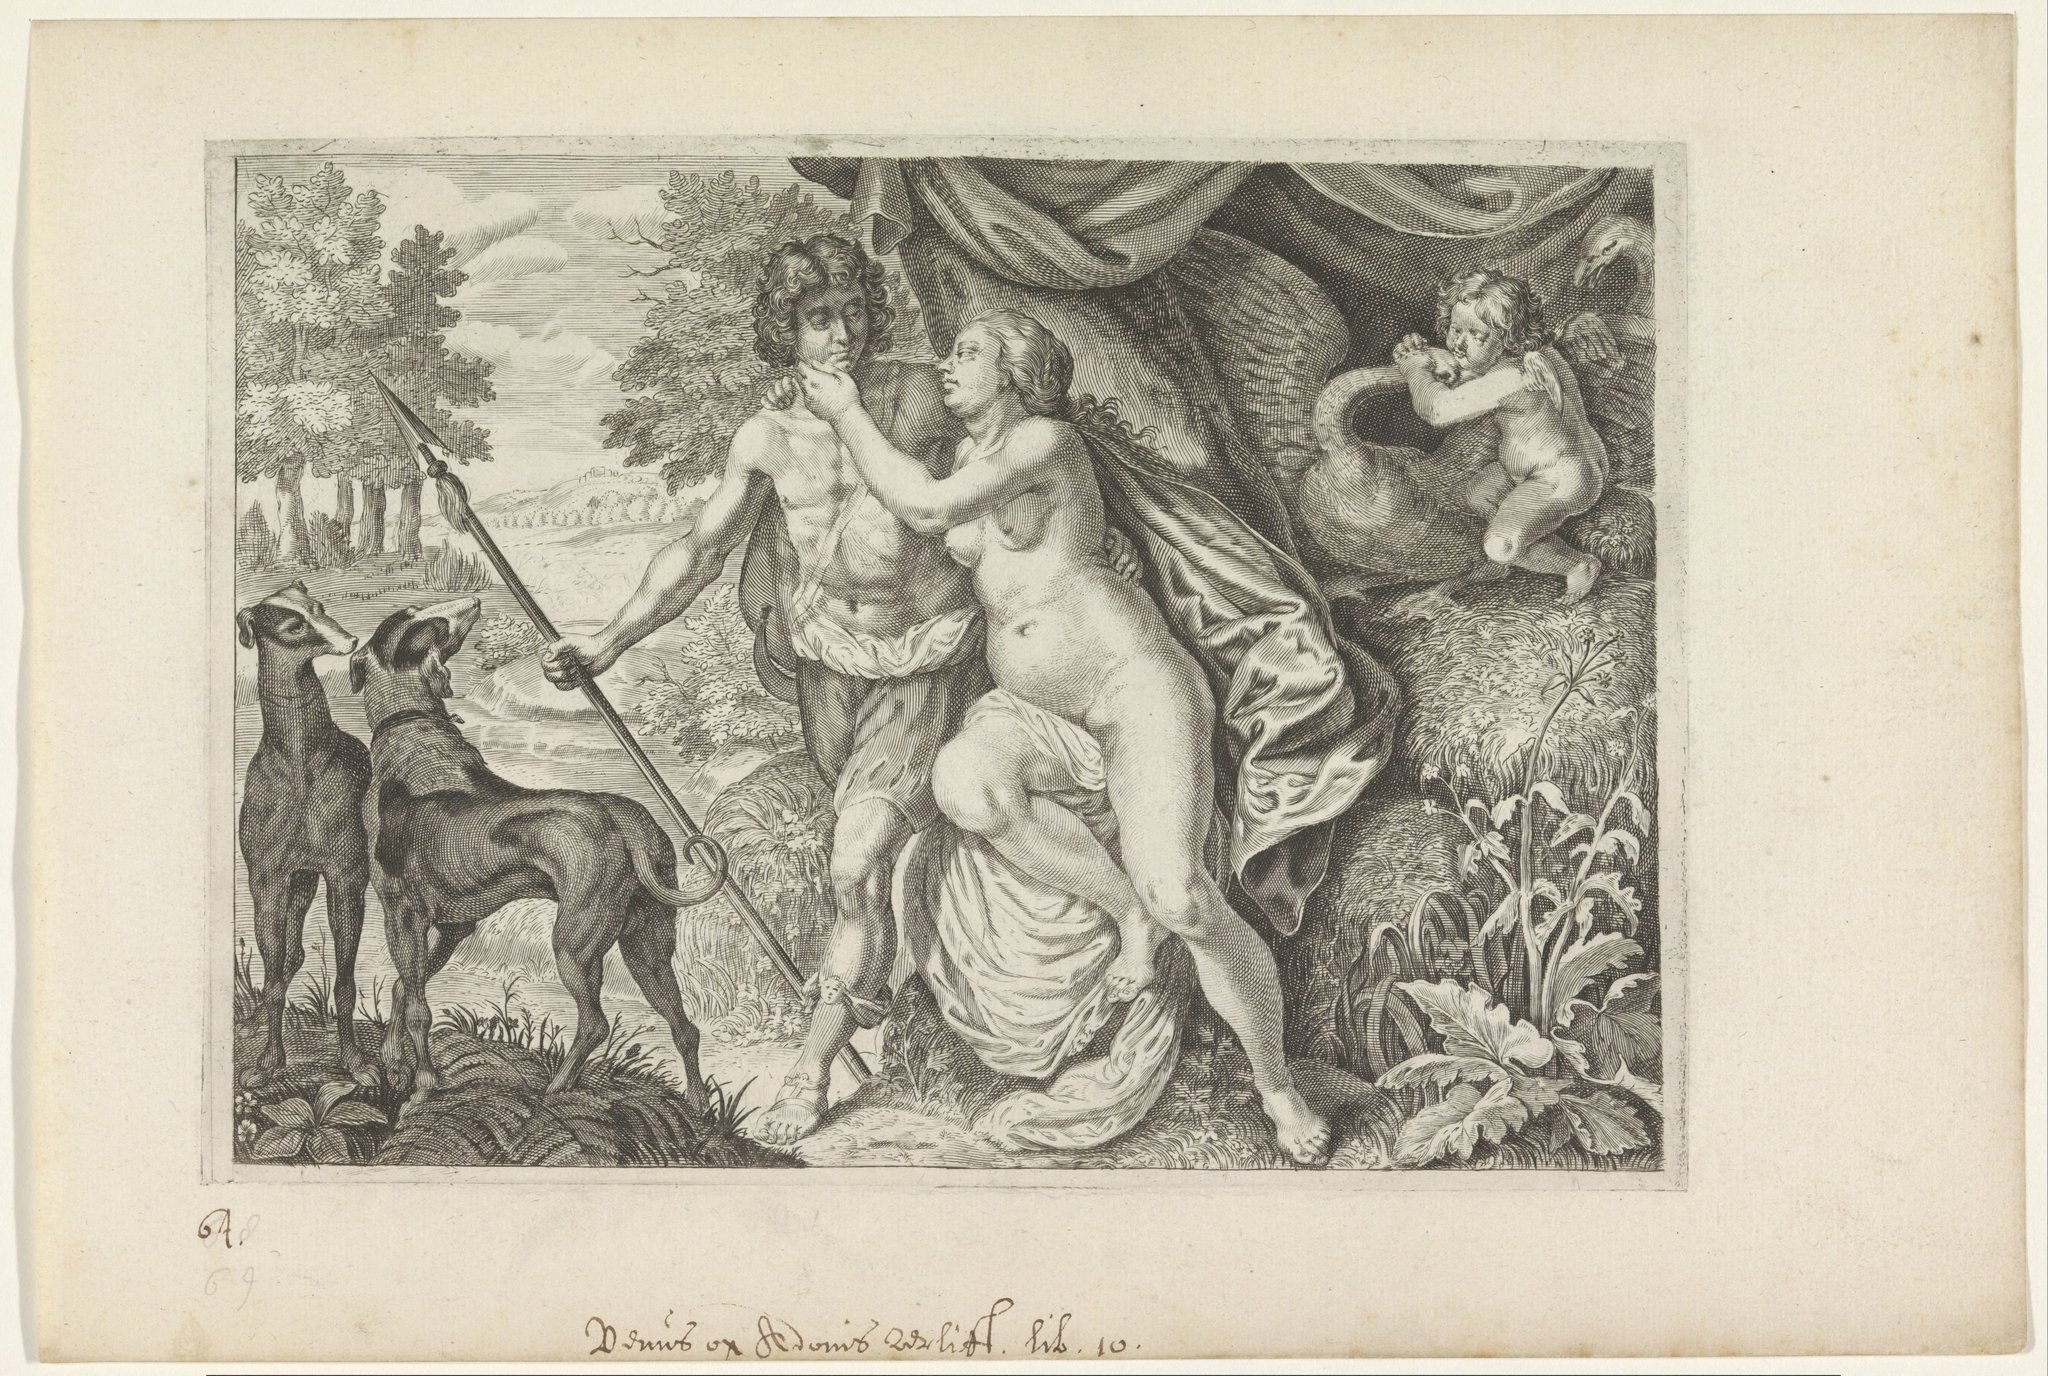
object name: print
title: Venus en Adonis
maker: crispijn van de passe (ii)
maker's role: draughtsman, print maker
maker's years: 1594-1670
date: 1636-1670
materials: paper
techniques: engraving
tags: venus and adonis as lovers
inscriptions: number: ‘64’, annotation: ‘Venus op Adonis verlieft. lib. 10.’, collector's mark: ‘Hinloopen’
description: Deze incomplete serie, bestaande uit 77 van de in totaal 85 prenten met scènes uit Ovidius' Metamorfosen, werd in 1709 samen met Ovidius-illustraties van Tempesta, Goltzius en Le Pautre in één album, Schijnvoet nummer 43, ingebonden. In de negentiende eeuw werd deze band weer uit elkaar gehaald. De ambitieuze reeks naar ontwerpen van ondermeer Jacob Pynas, Roeland Savery, Pieter Clouwet, Rubens en Rembrandt is nooit voltooid door de De Passes. De reeks werd uiteindelijk in 1677 in boekvorm uitgegeven in Brussel door Piere Du Rayer en Francois Foppes. Als losse prenten was de reeks alleen bekend uit de groep prenten afkomstig uit de collectie Hinloopen (1619-1708) die zich in het Rijksprentenkabinet bevindt. Deze groep is uitgebreid beschreven door Jan van der Waals in zijn Hinloopen-catalogus (zie: ''Een onbekende editie van een serie Ovidius-illustraties'' in De prentschat van Michiel Hinloopen, 1988, p. 79-102 en ook Ilja M. Veldman, 'The Ovid Project' in Crispijn de Passe and his Progeny (1564-1670) A Century of Print Production, 2001, pp. 287-290).